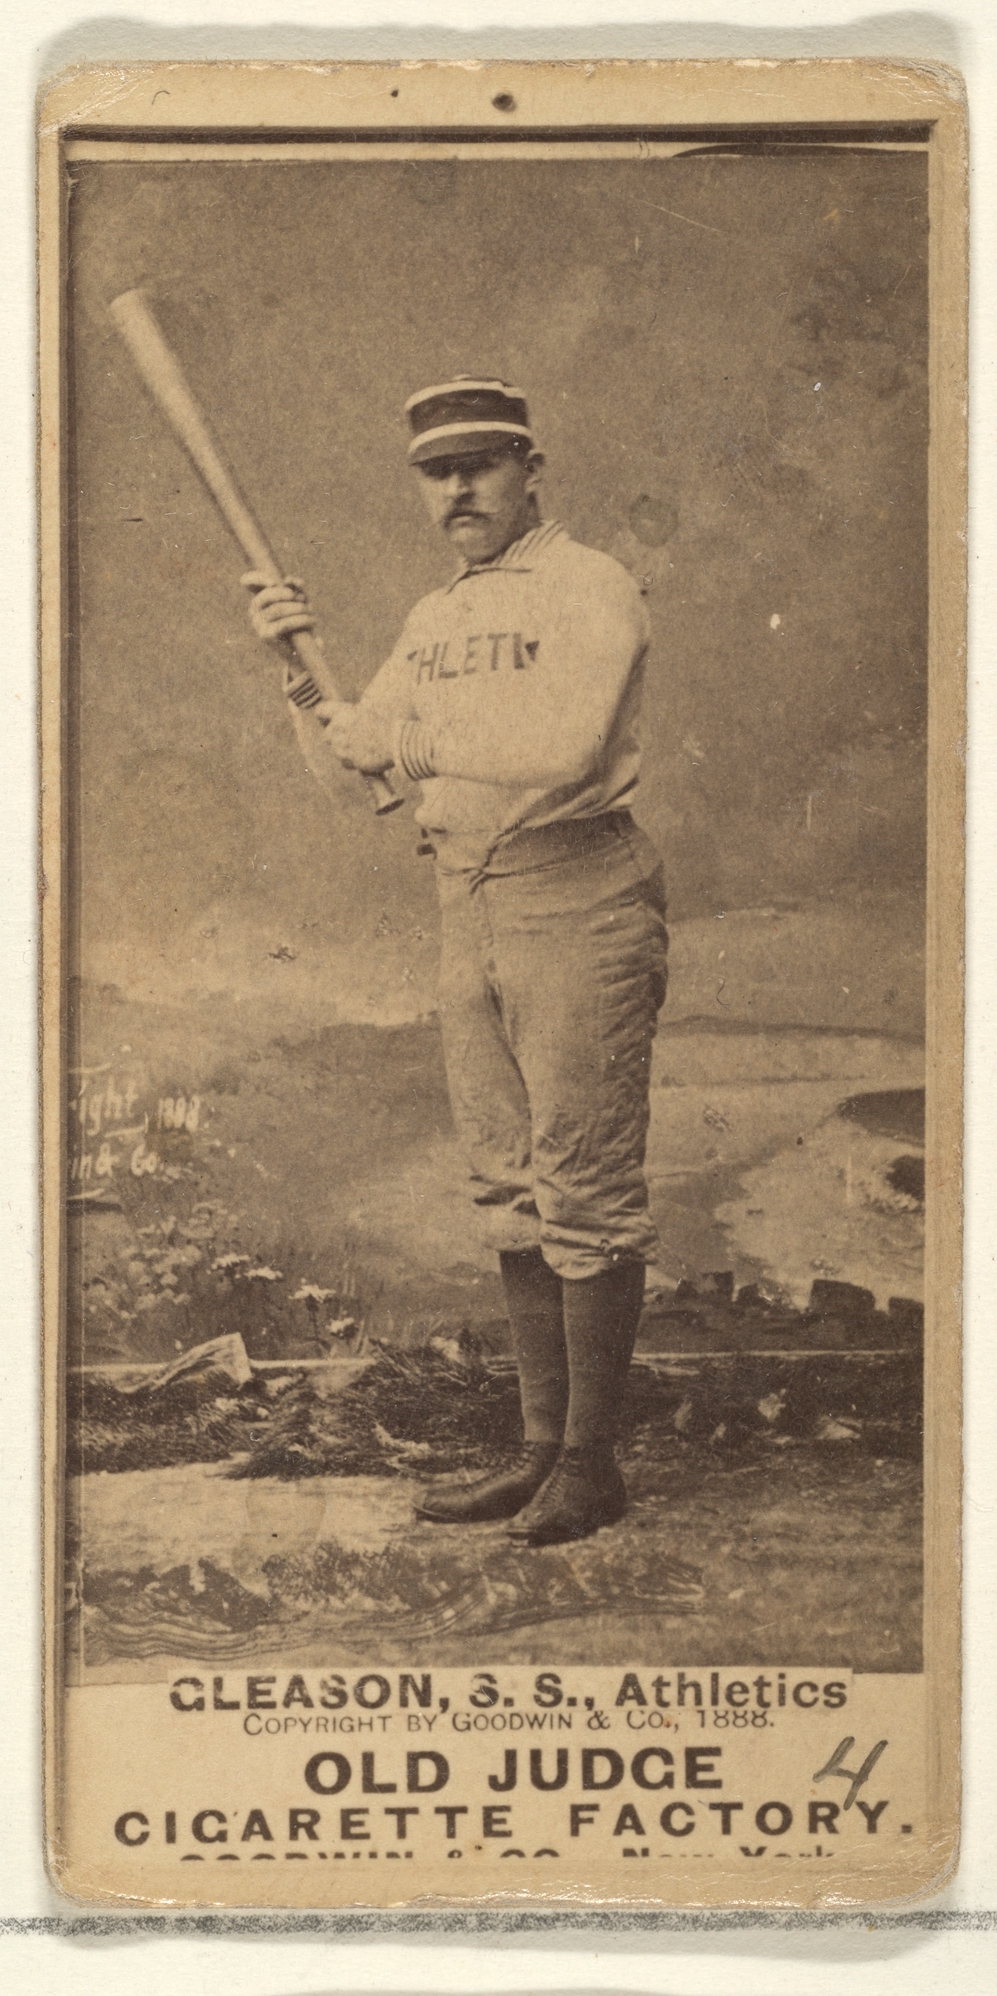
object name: baseball card, photograph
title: Gleason, Shortstop, Philadelphia Athletics, from the Old Judge series (N172) for Old Judge Cigarettes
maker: goodwin & company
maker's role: publisher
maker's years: 1850-1950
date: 1888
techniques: albumen silver print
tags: men,portraits,baseball,athletes